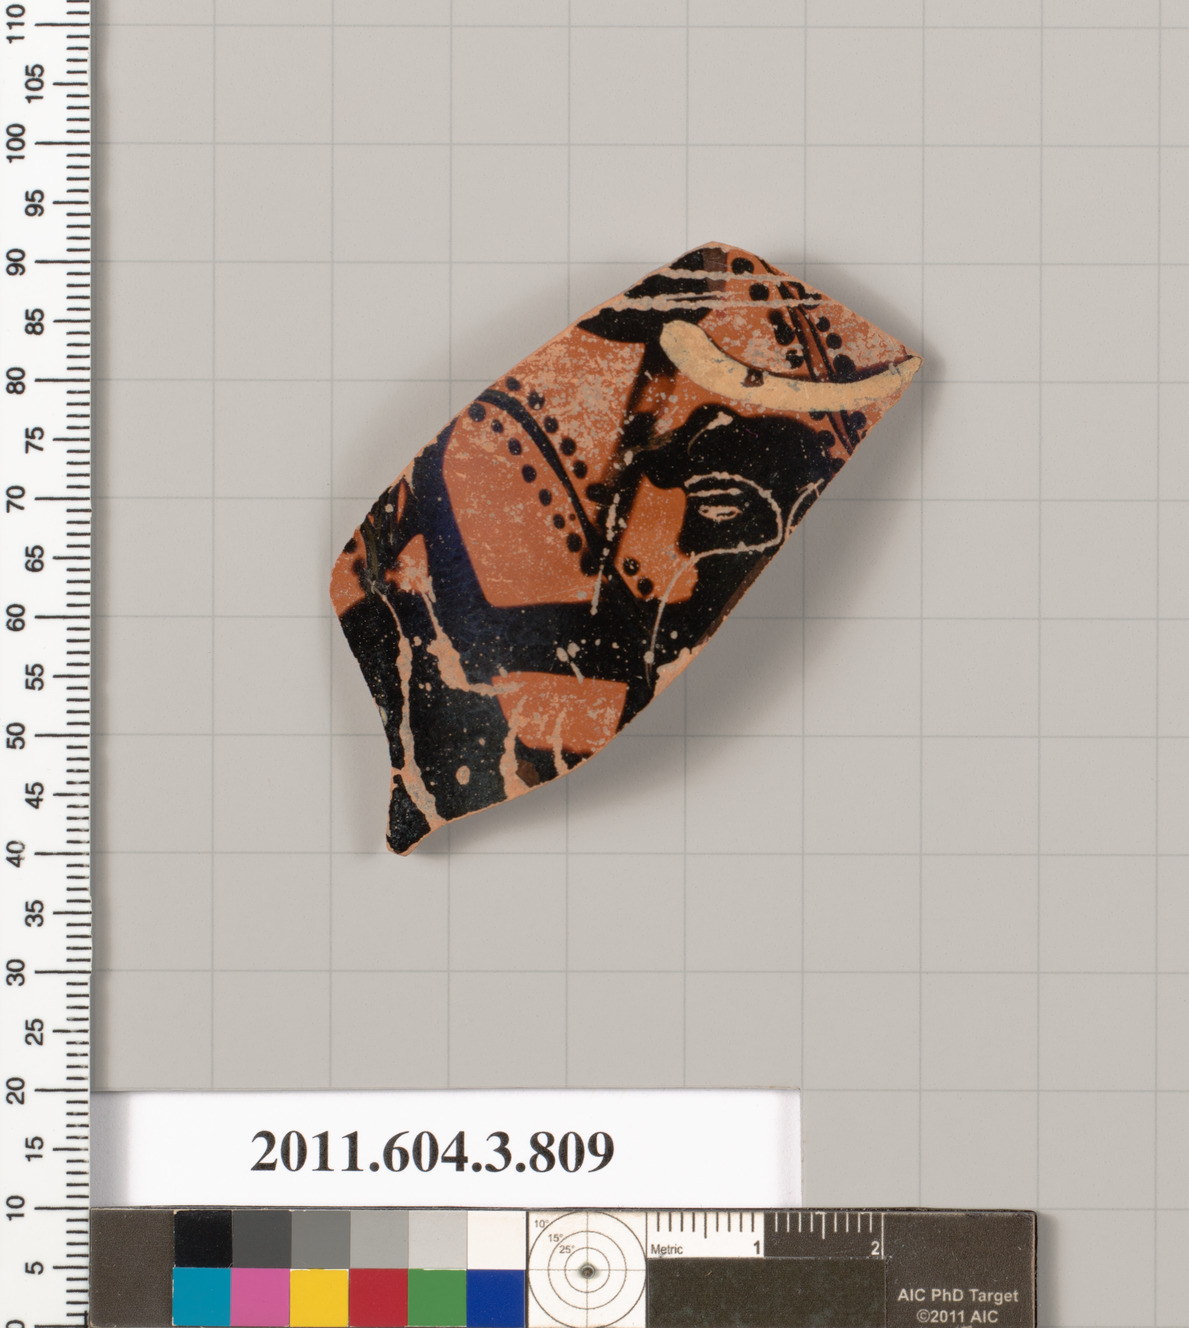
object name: lekythos fragment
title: Terracotta fragment of a lekythos (oil flask)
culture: greek, attic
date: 534-468 BCE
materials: terracotta